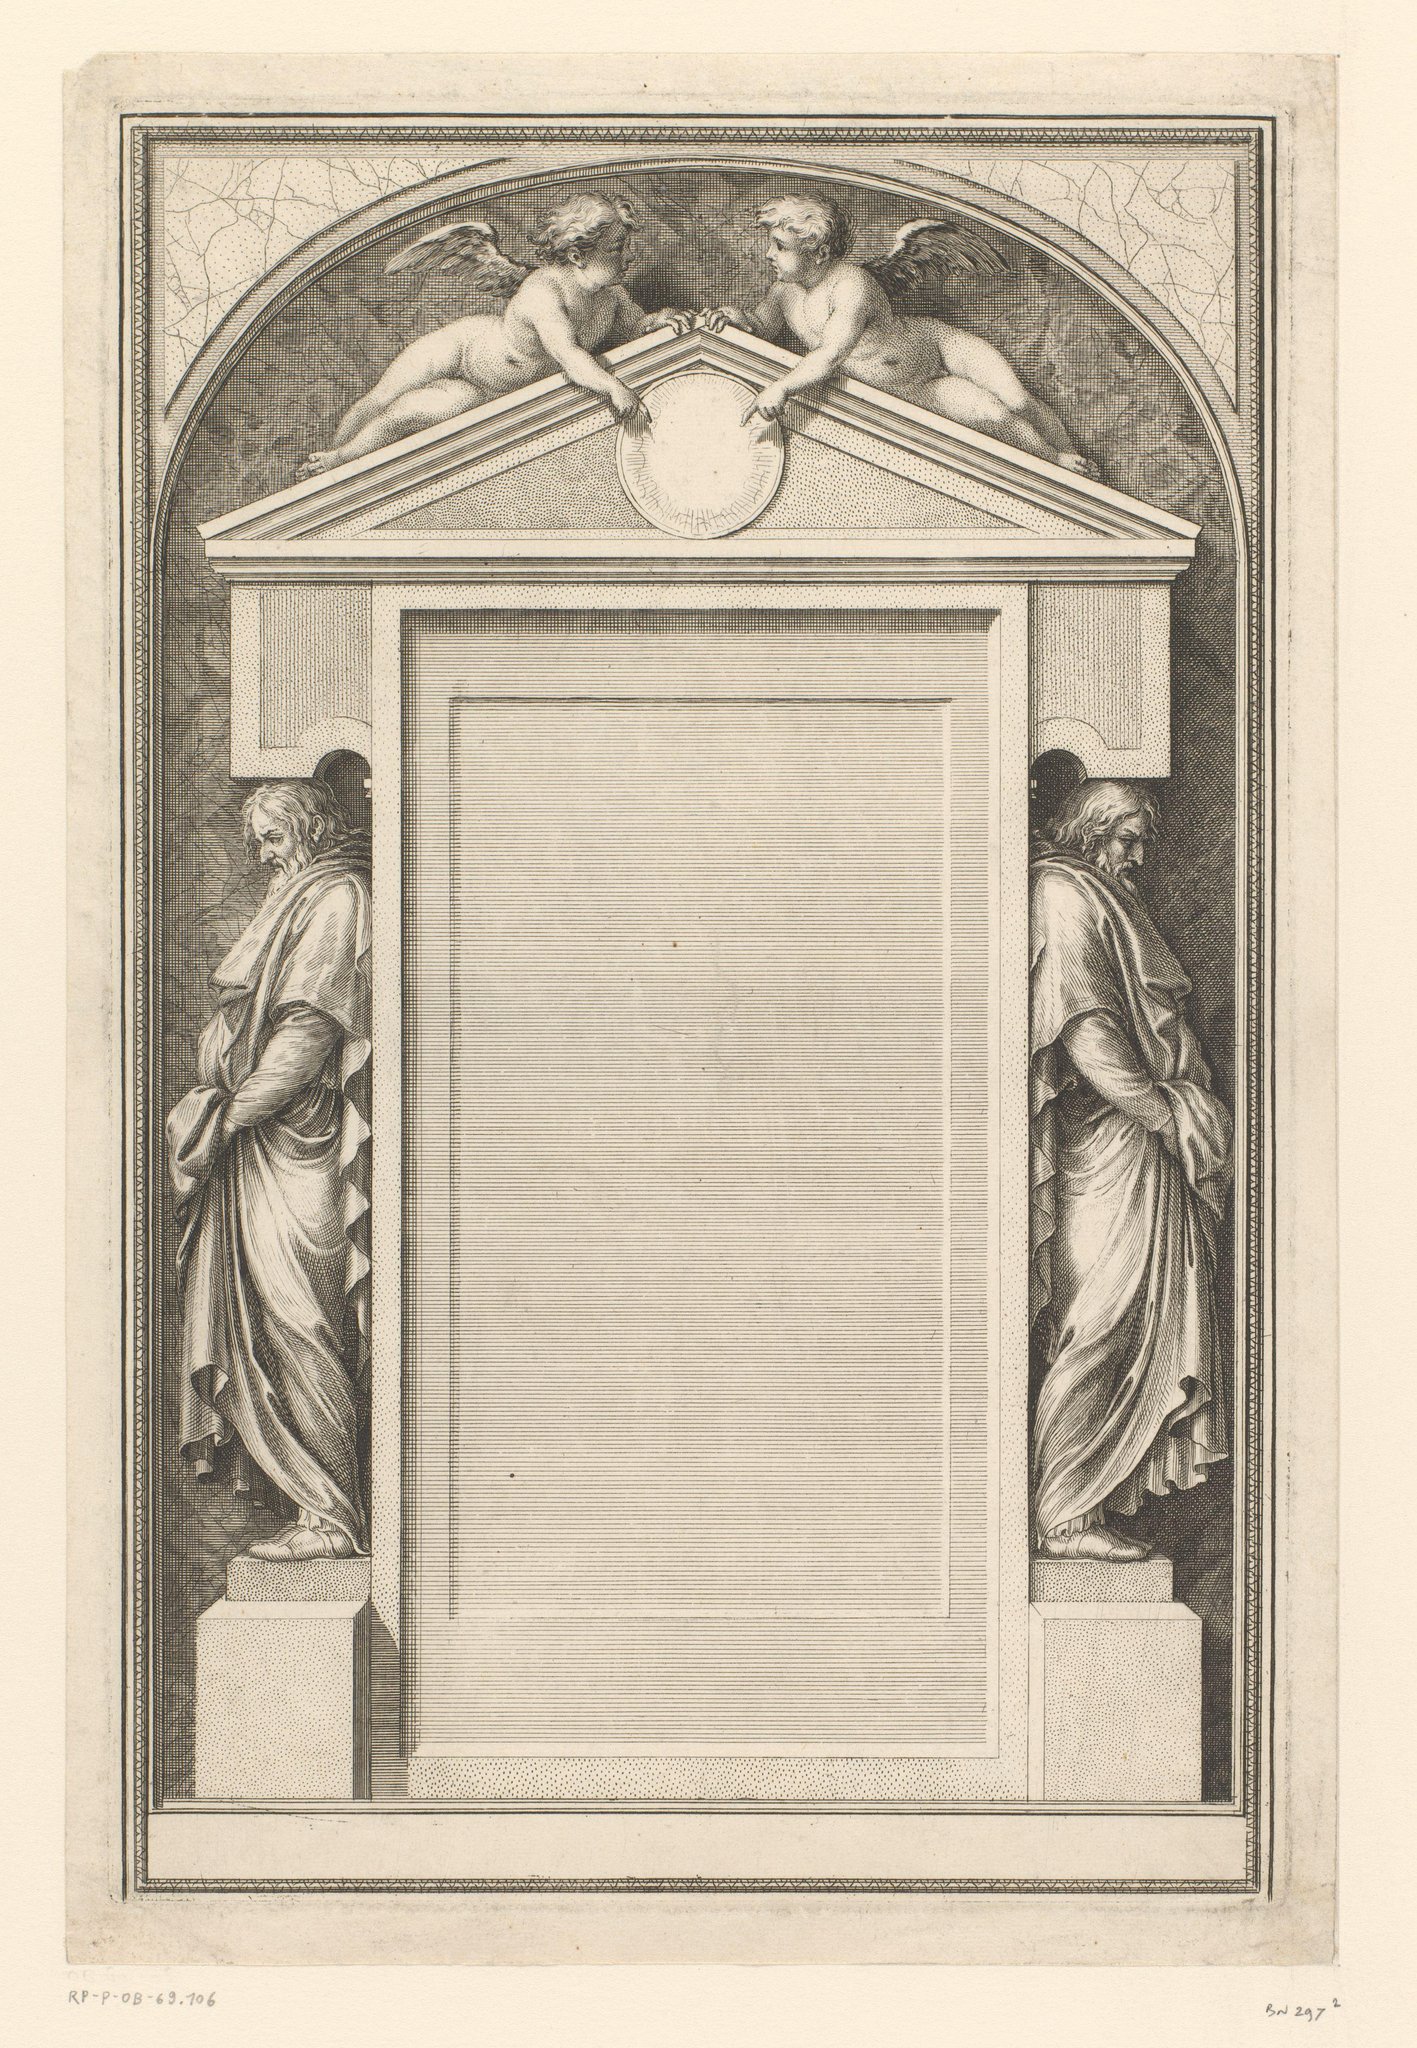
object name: titelprent, frontispice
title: Titelprent met fronton geflankeerd door twee heiligen en twee putti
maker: sébastien leclerc (i)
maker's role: print maker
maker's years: 1637-1714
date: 1647-1714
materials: paper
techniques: engraving, etching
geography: france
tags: other architectural details (with name), saints, cupids: 'amores', 'amoretti', 'putti'